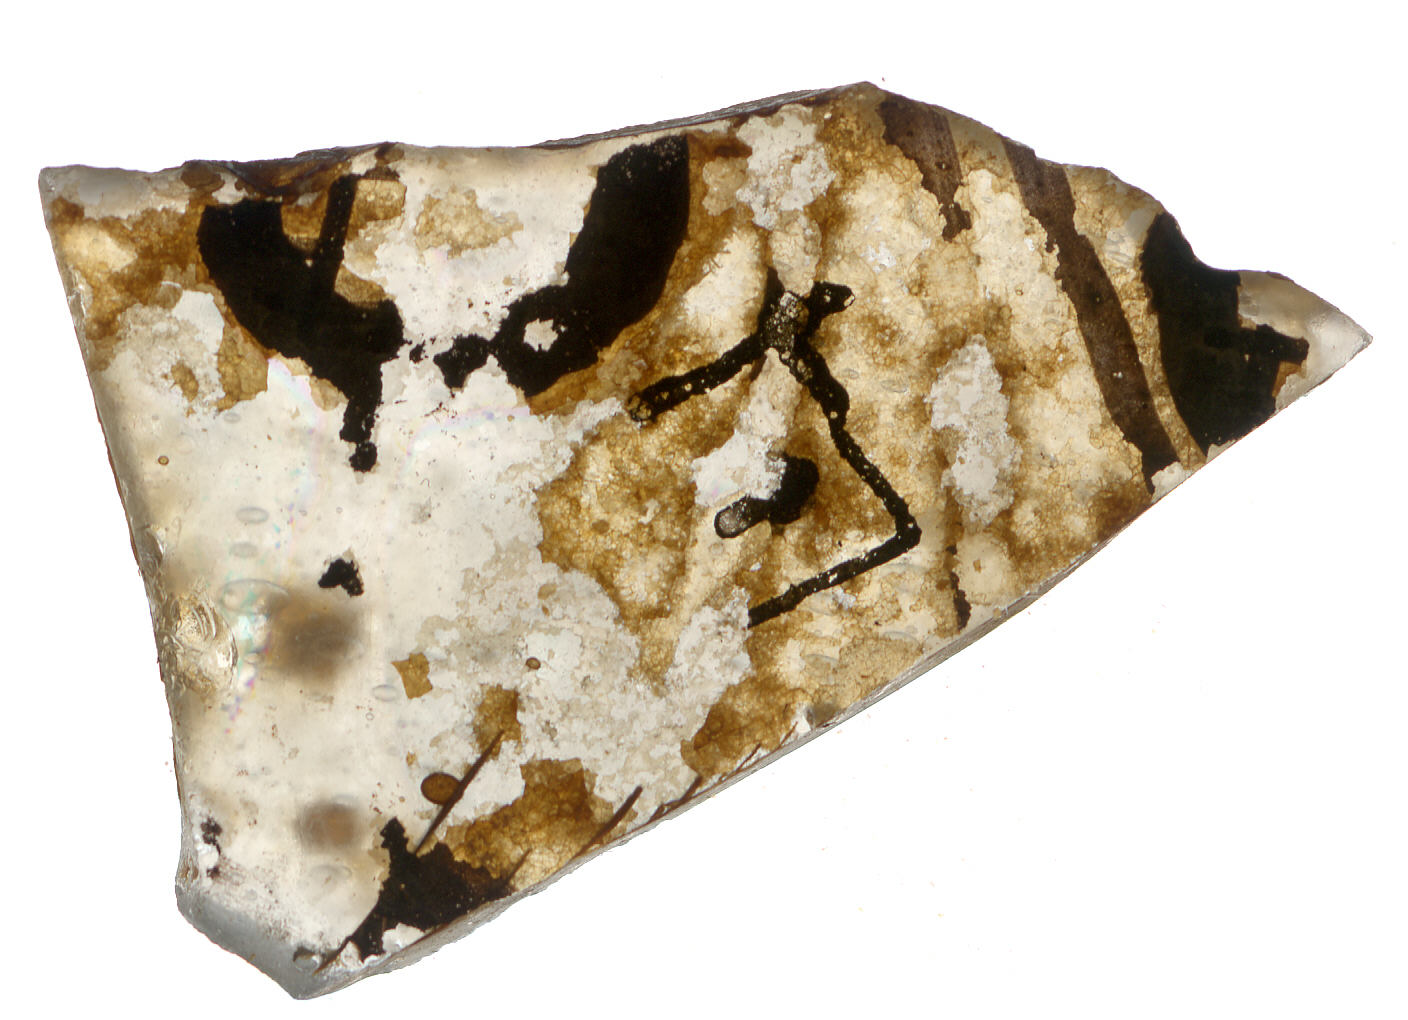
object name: fragment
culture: crusader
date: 1201-1300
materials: glass